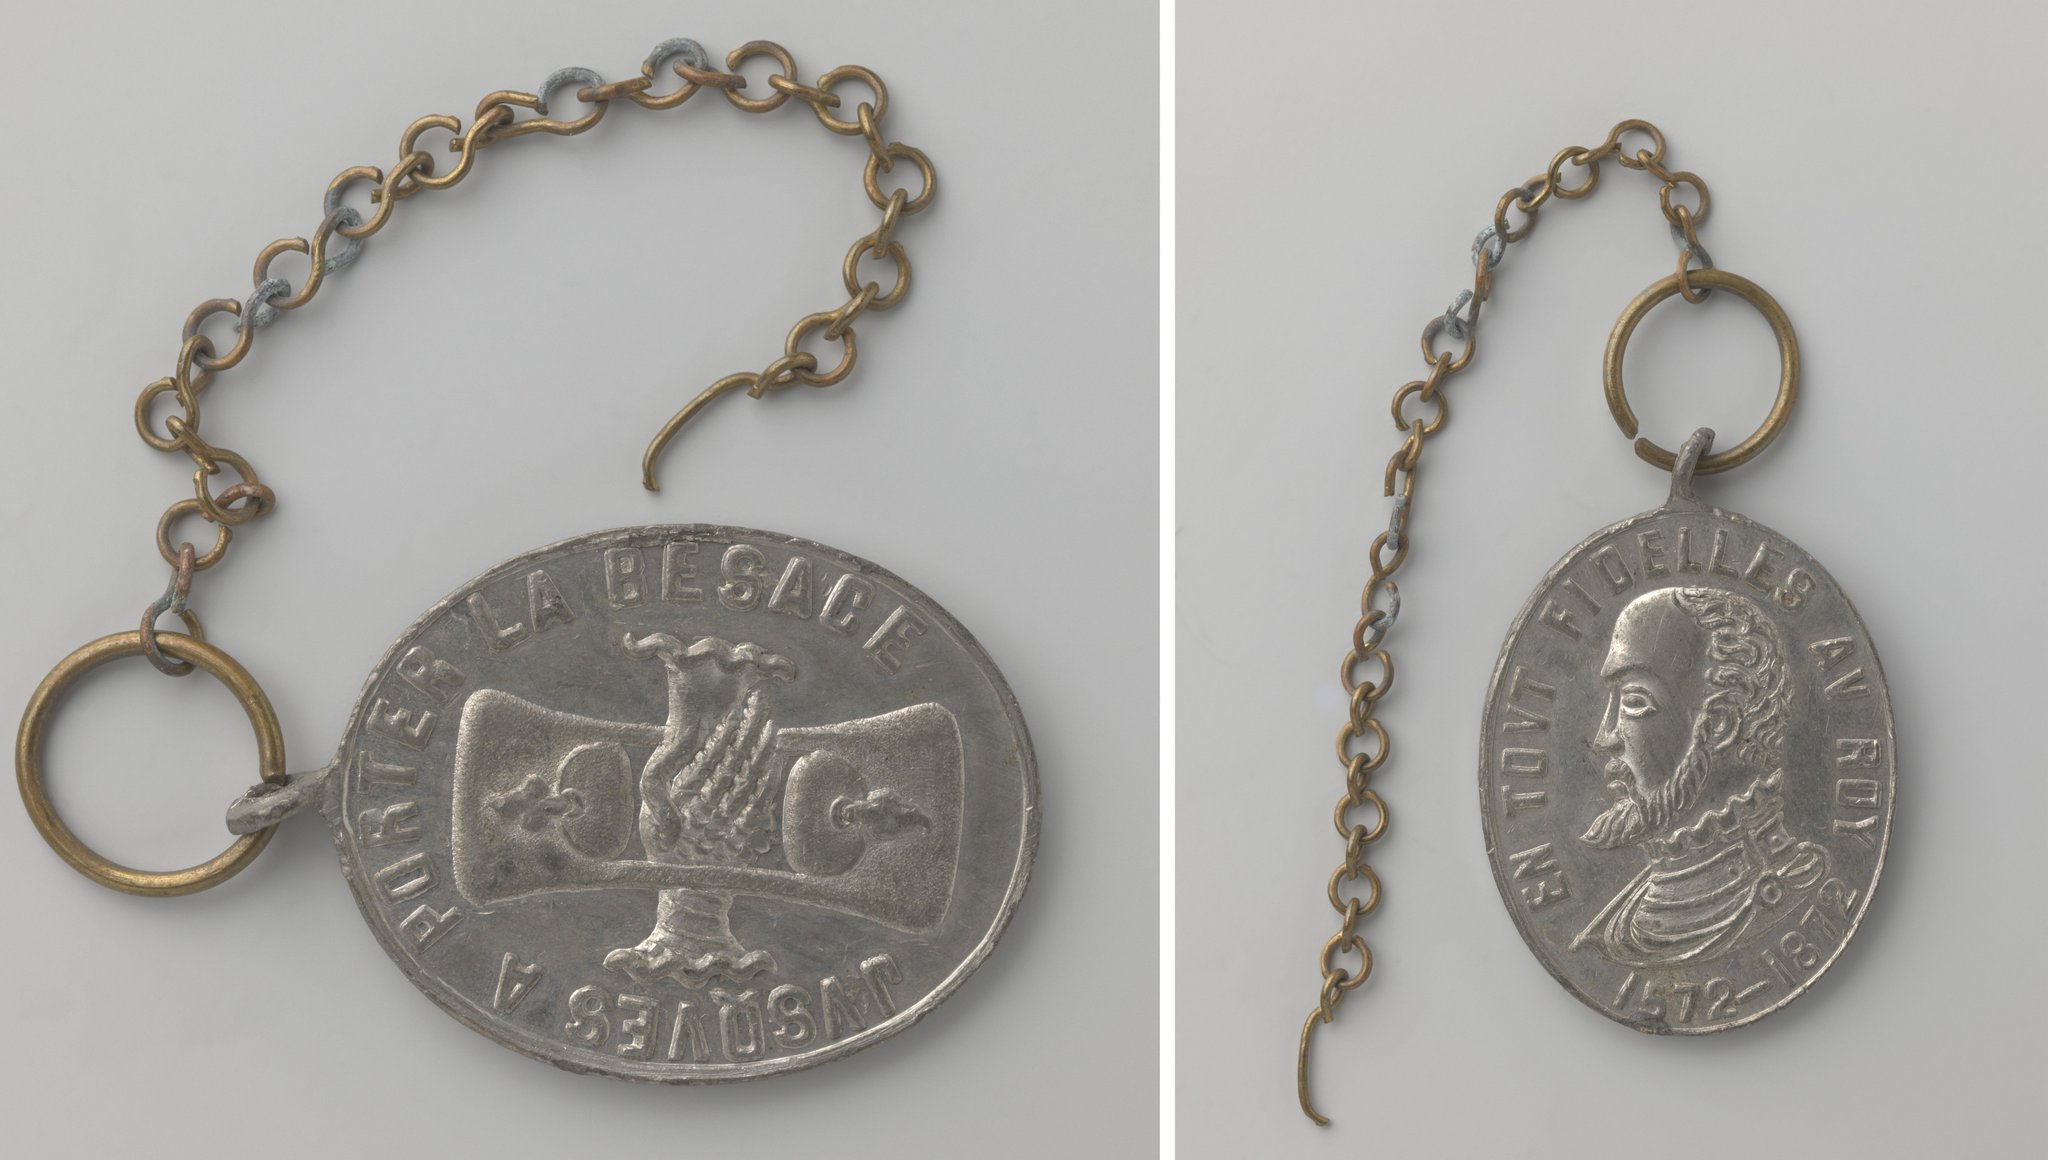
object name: history medal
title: Driehonderdjarige herdenking van de inname van Den Briel 1872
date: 1872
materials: aluminum, brass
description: Ovalen tinnen penning met oog, draagring en kettinkje, imitatie van een geuzenpenning: op de voorzijde het geharnaste borstbeeld van Philips II naar links met omschrift, op de keerzijde ineengedrukte handen op een bedeltas, met omschrift.